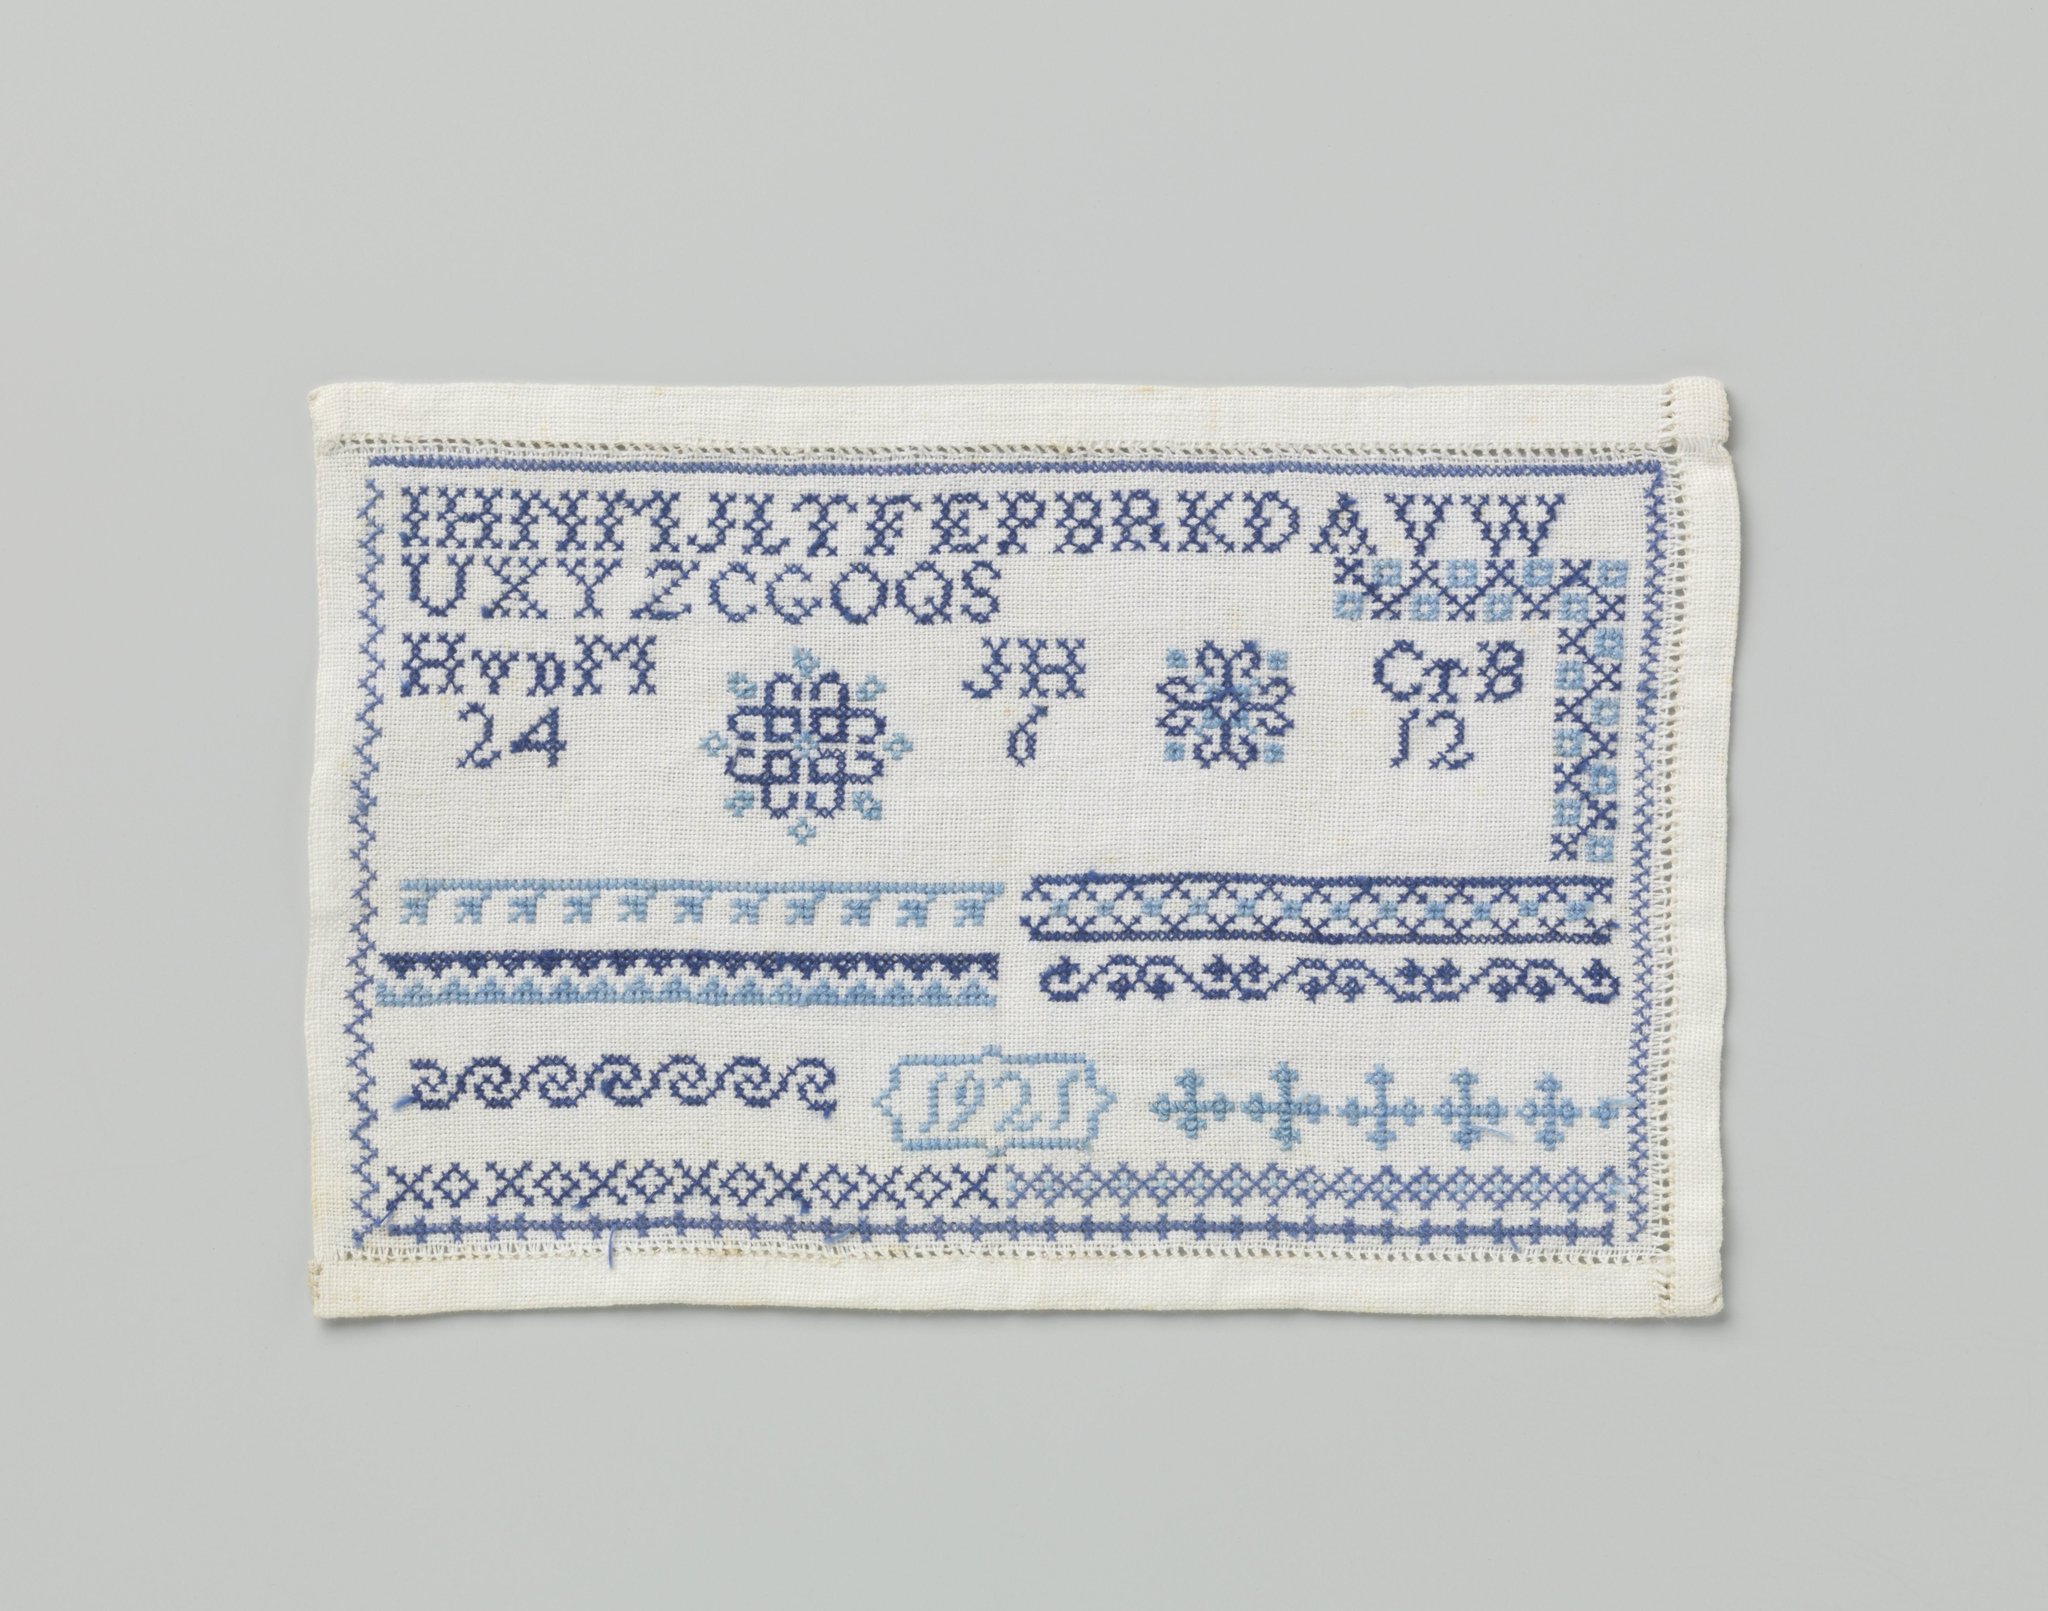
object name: merkdoek, merklap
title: Merklap van blauwe katoen op katoen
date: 1921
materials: cotton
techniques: embroidered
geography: amsterdam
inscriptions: date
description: Merklap van katoen op katoen. Het borduurwerk heeft de initialen HvdM, JH C+B, de getallen 24, 6, 12 en de datering 1921.